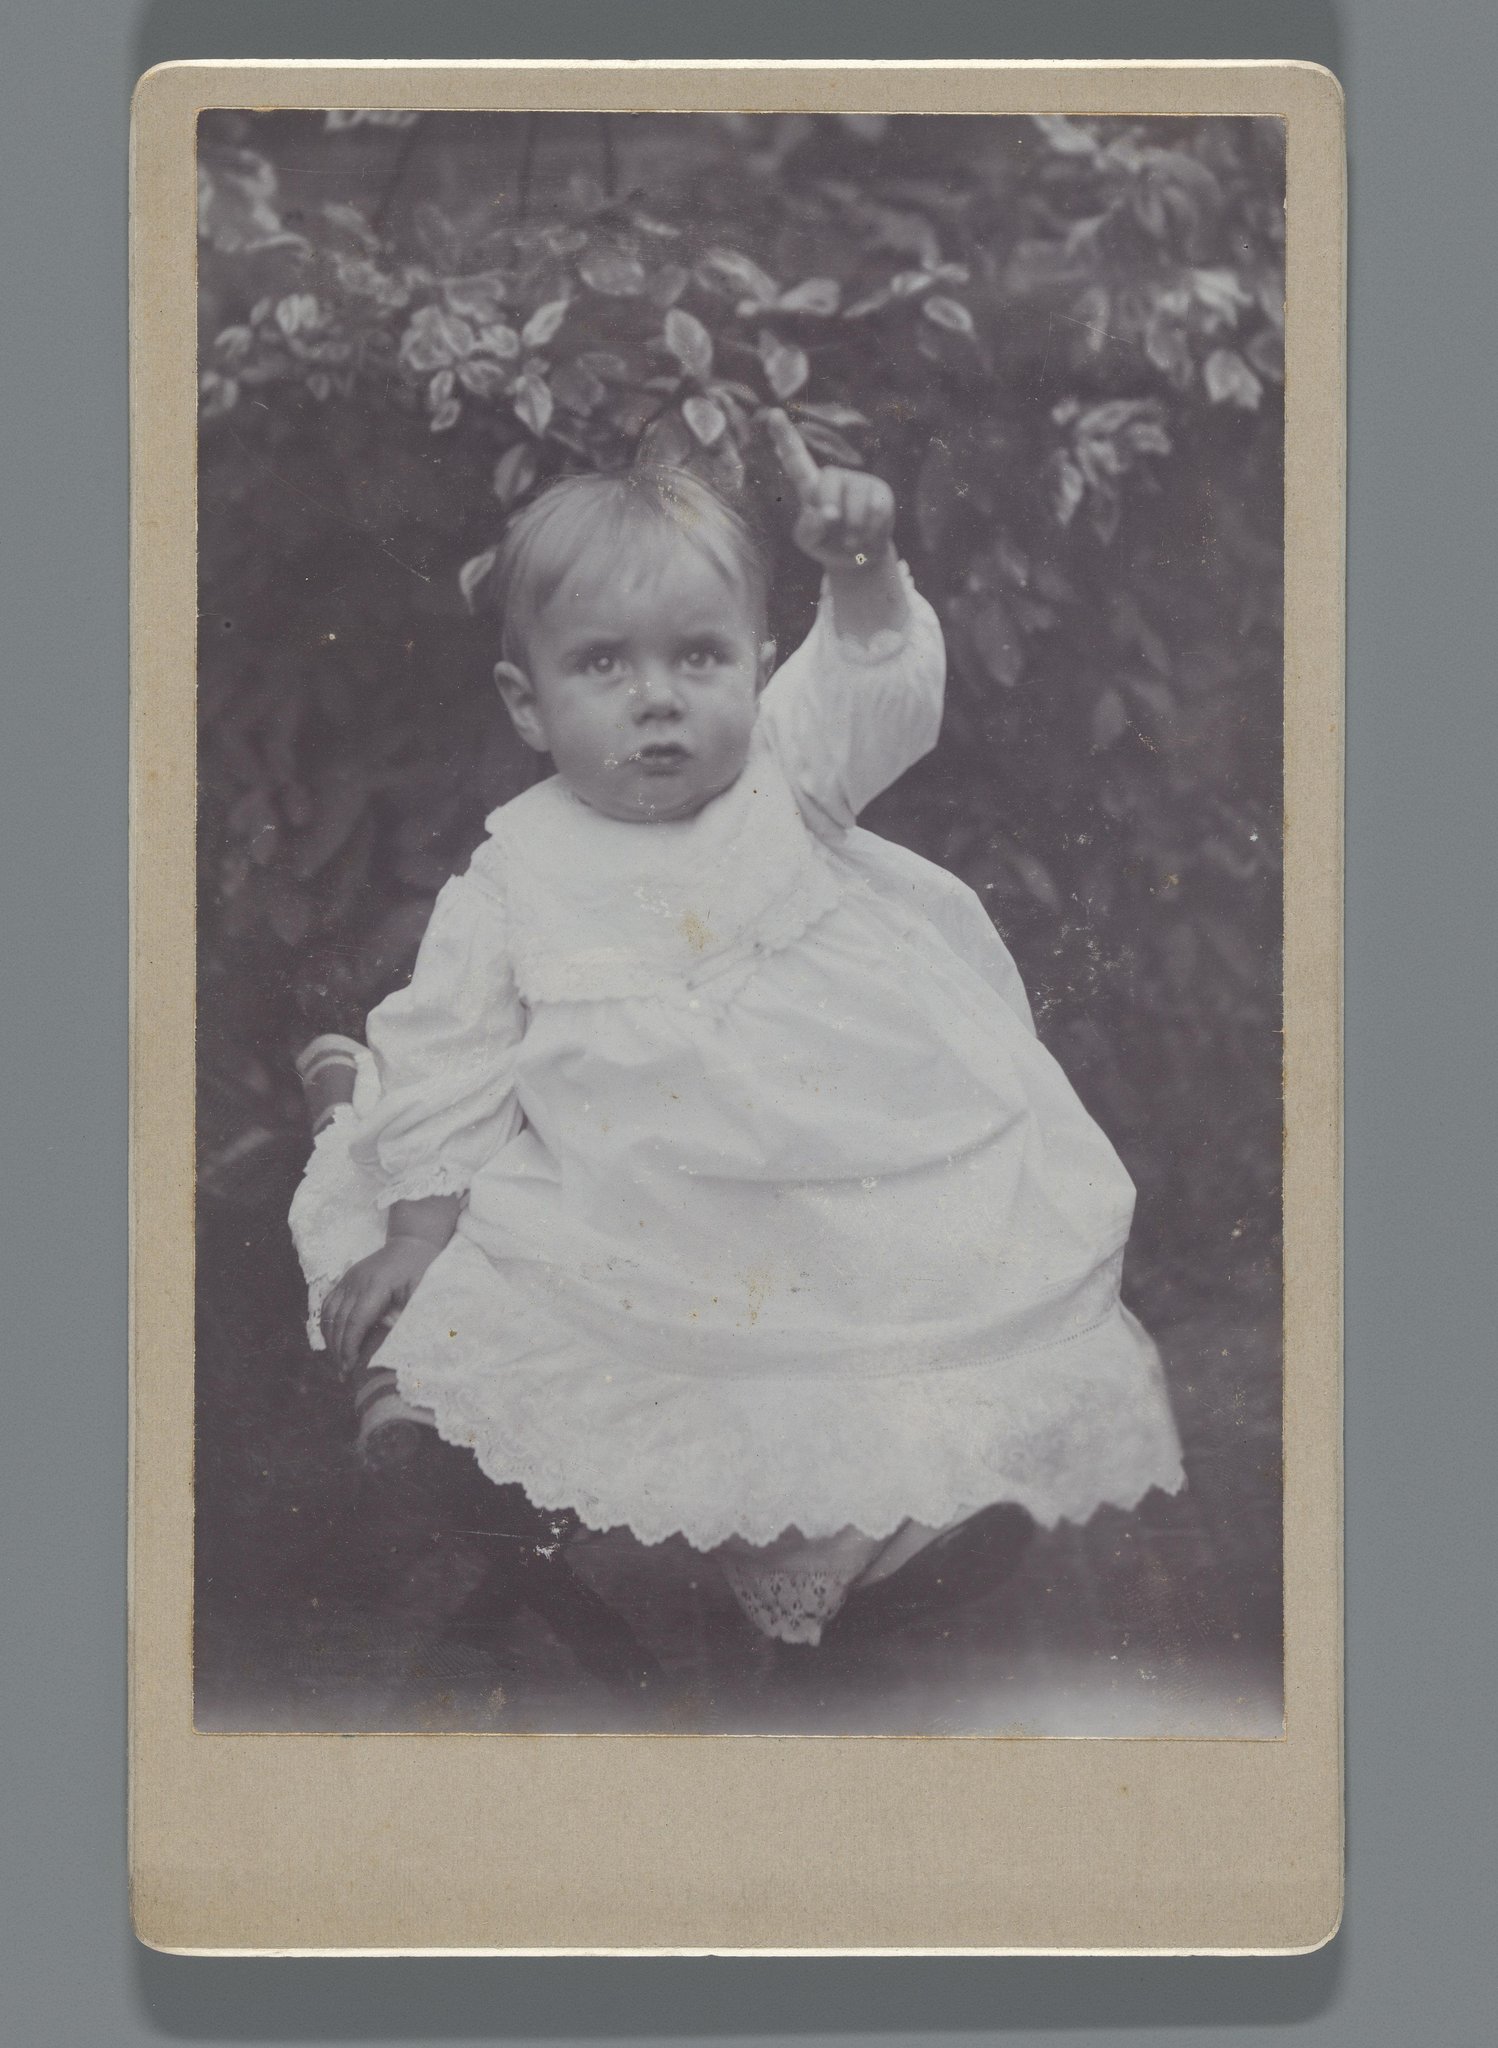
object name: cabinet photograph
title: Portret van een onbekend kind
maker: Anonymous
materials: paper, cardboard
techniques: gelatin silver print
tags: child, anonymous historical person portrayed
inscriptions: inscription: ‘voor Trijntje v.d. Weide/ van Dudley Jager/ 21 September 1904.’